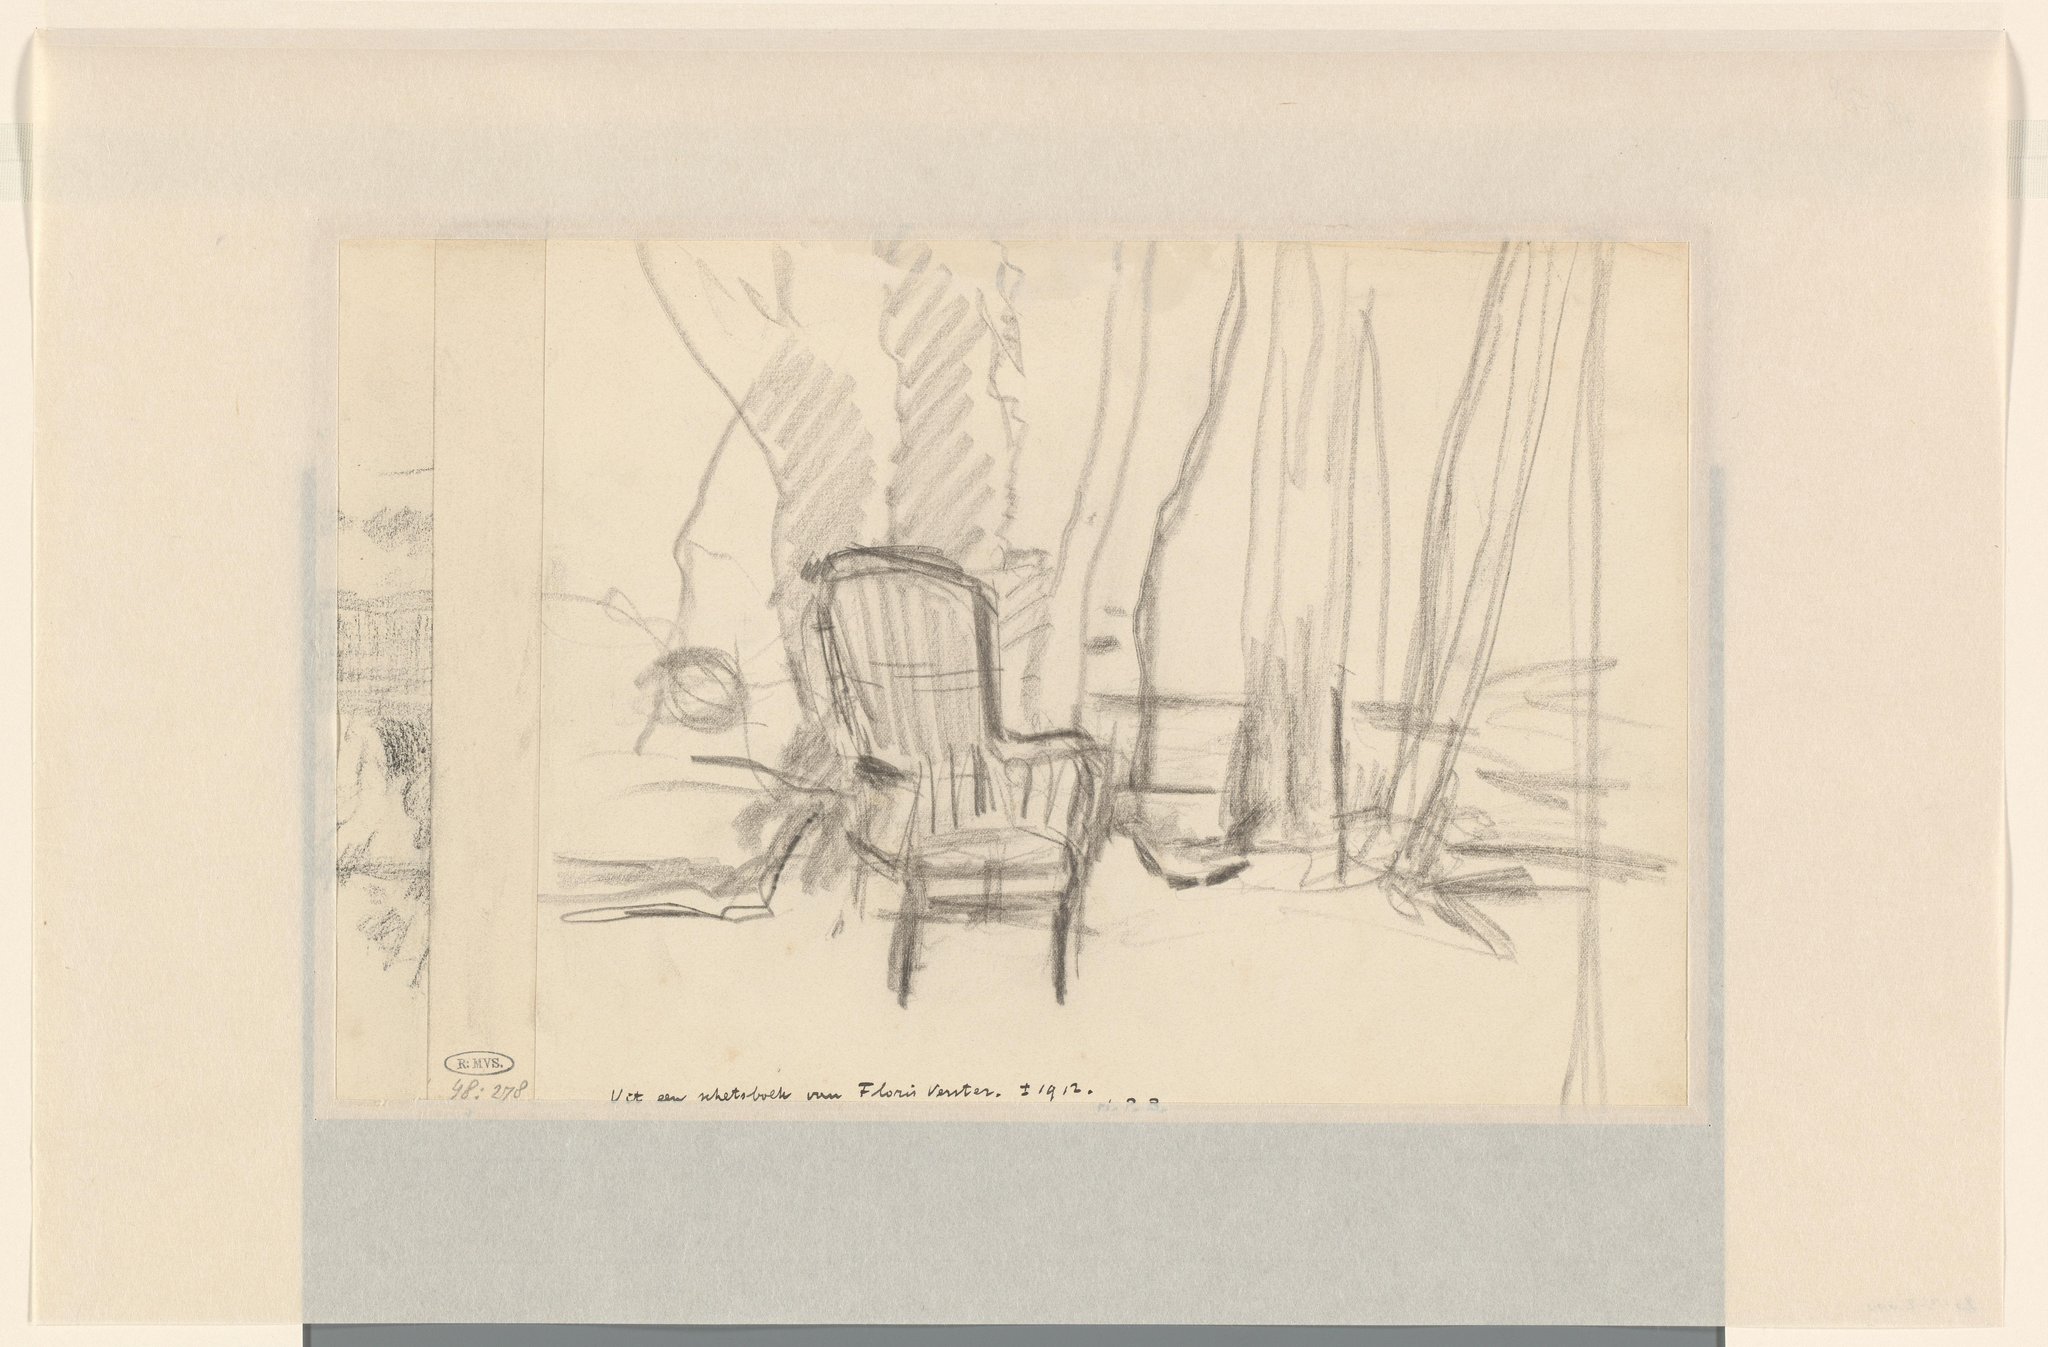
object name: drawing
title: Interieur met fauteuil voor gordijnen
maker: floris verster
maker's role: draughtsman, painter, print maker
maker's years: 1861-1927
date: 1871-1927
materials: chalk, paper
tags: communal rooms